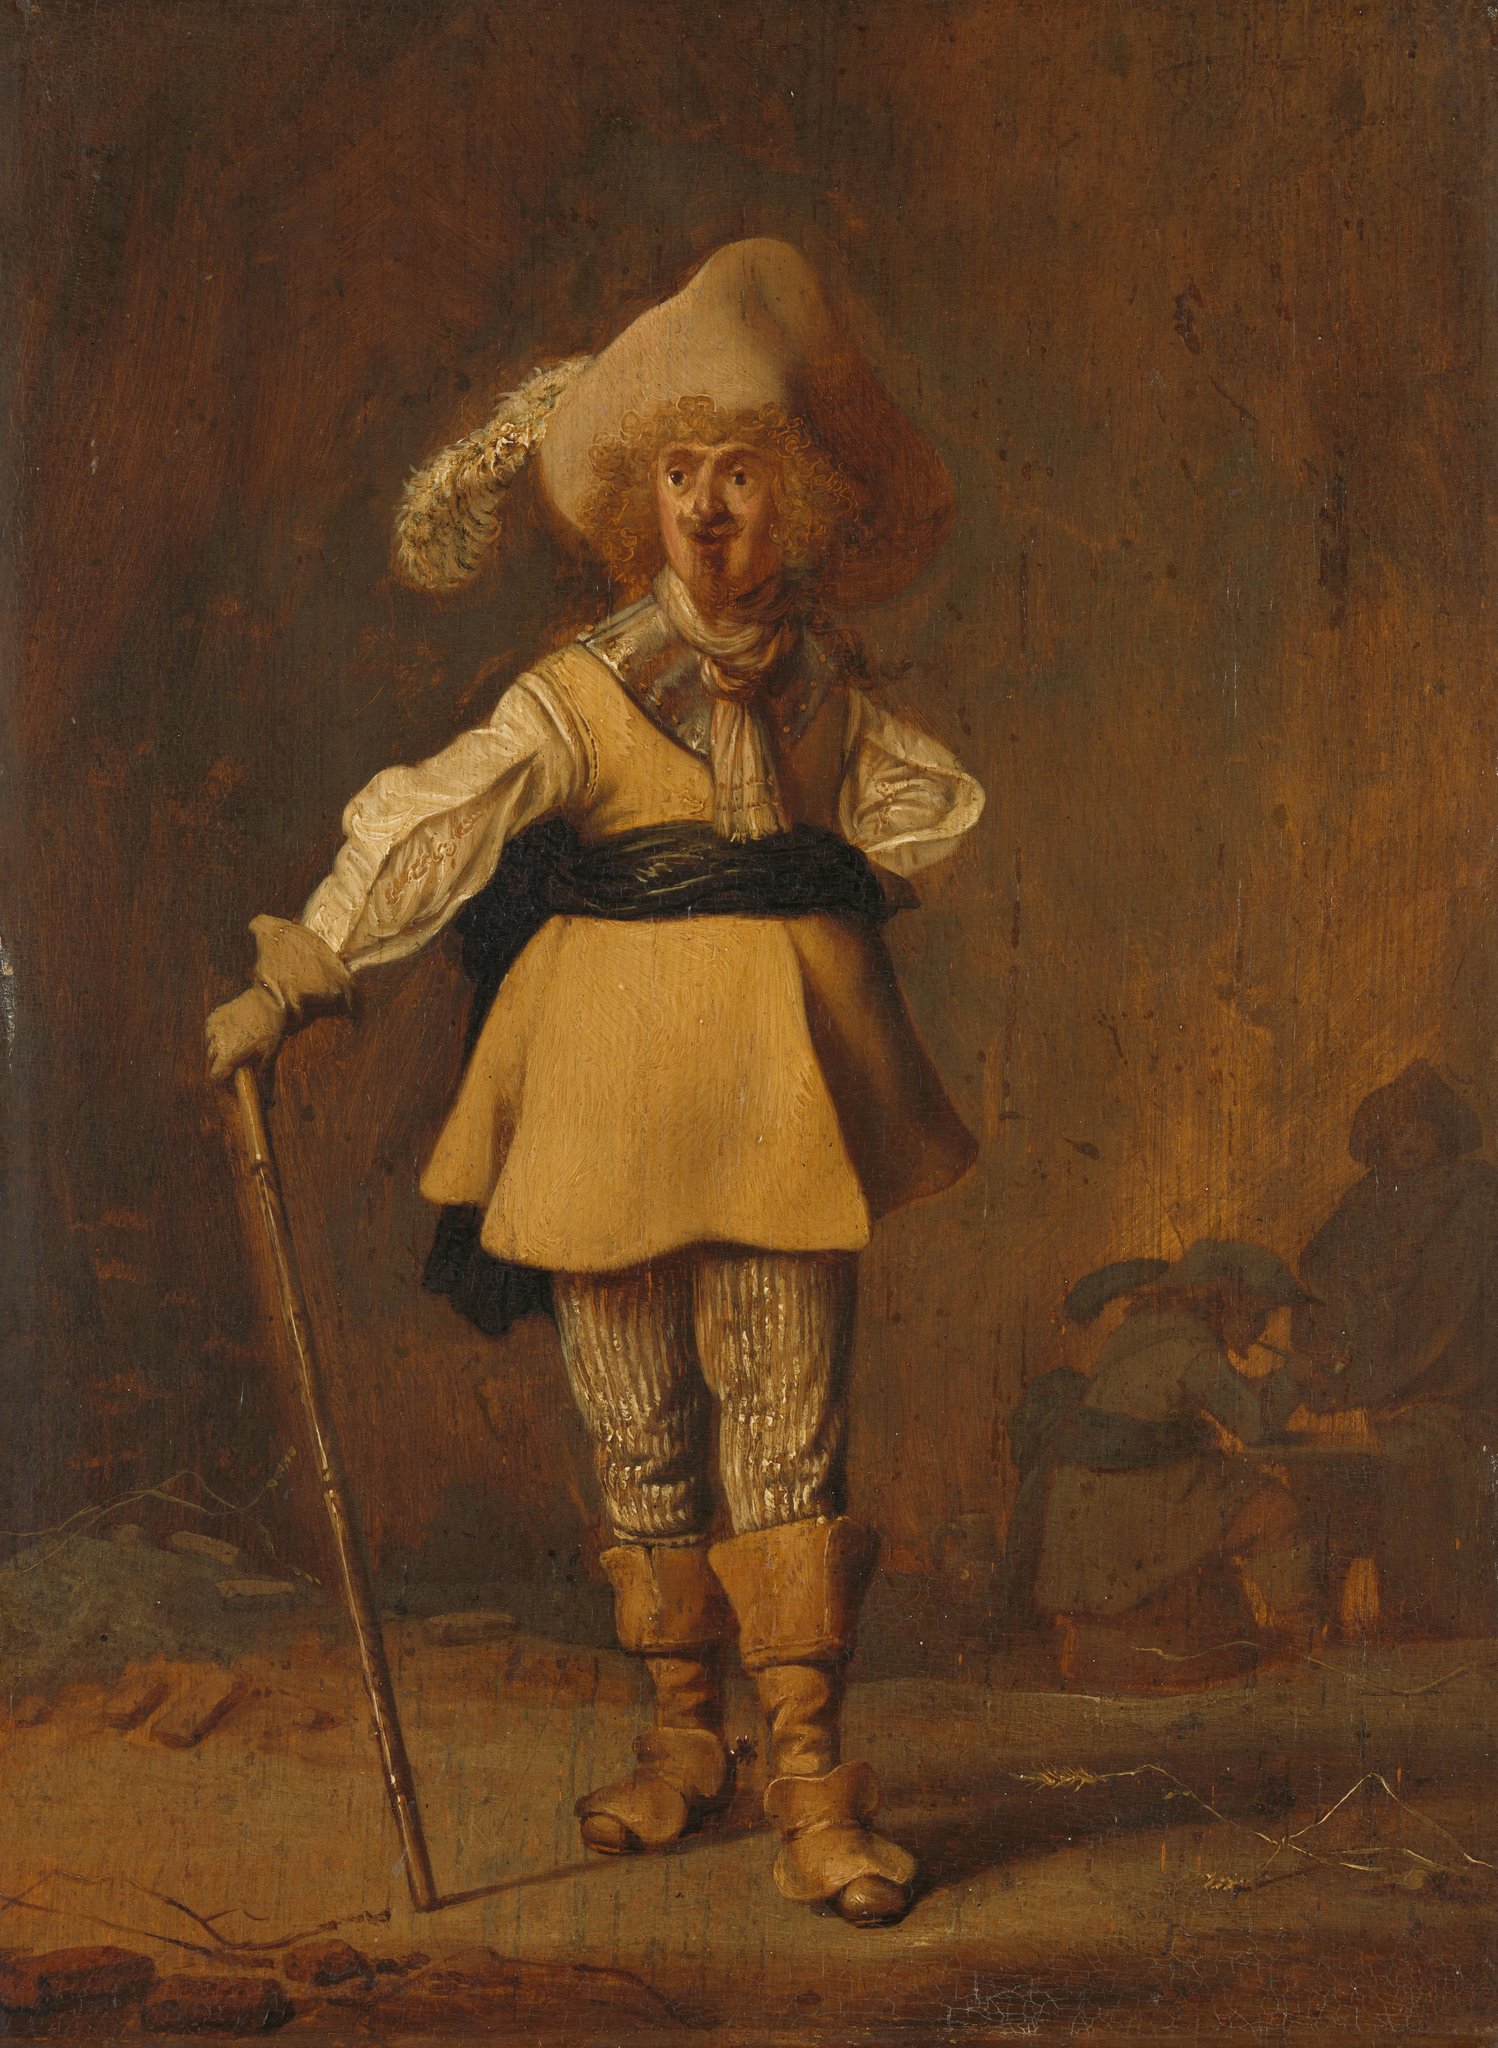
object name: painting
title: A Captain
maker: willem bartsius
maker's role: draughtsman, painter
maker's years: 1612-1639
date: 1622-1639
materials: oil, panel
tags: land forces (+ officers), warfare; military affairs (+ citizen soldiery, civil guard, citizen militia)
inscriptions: signature: ‘WB. f.’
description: Een kapitein, staande ten voeten uit met een stok in de hand. Op de achtergrond twee soldaten.